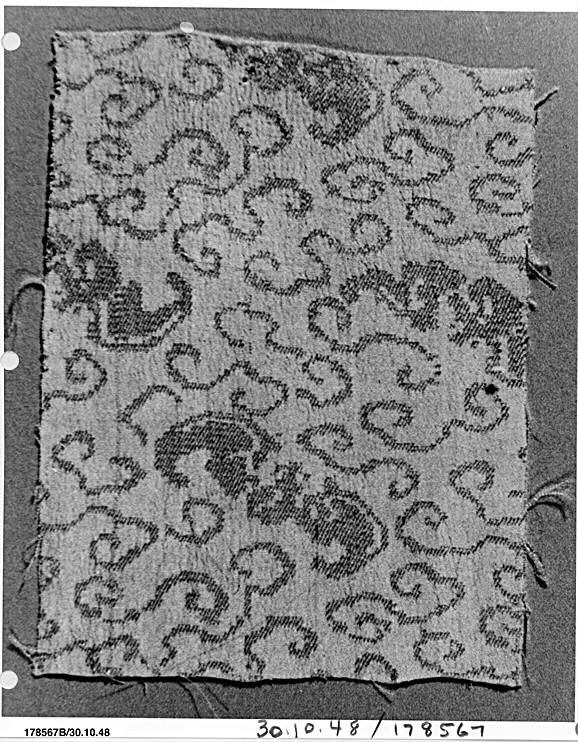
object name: piece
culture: chinese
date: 1801-1900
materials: silk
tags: bats